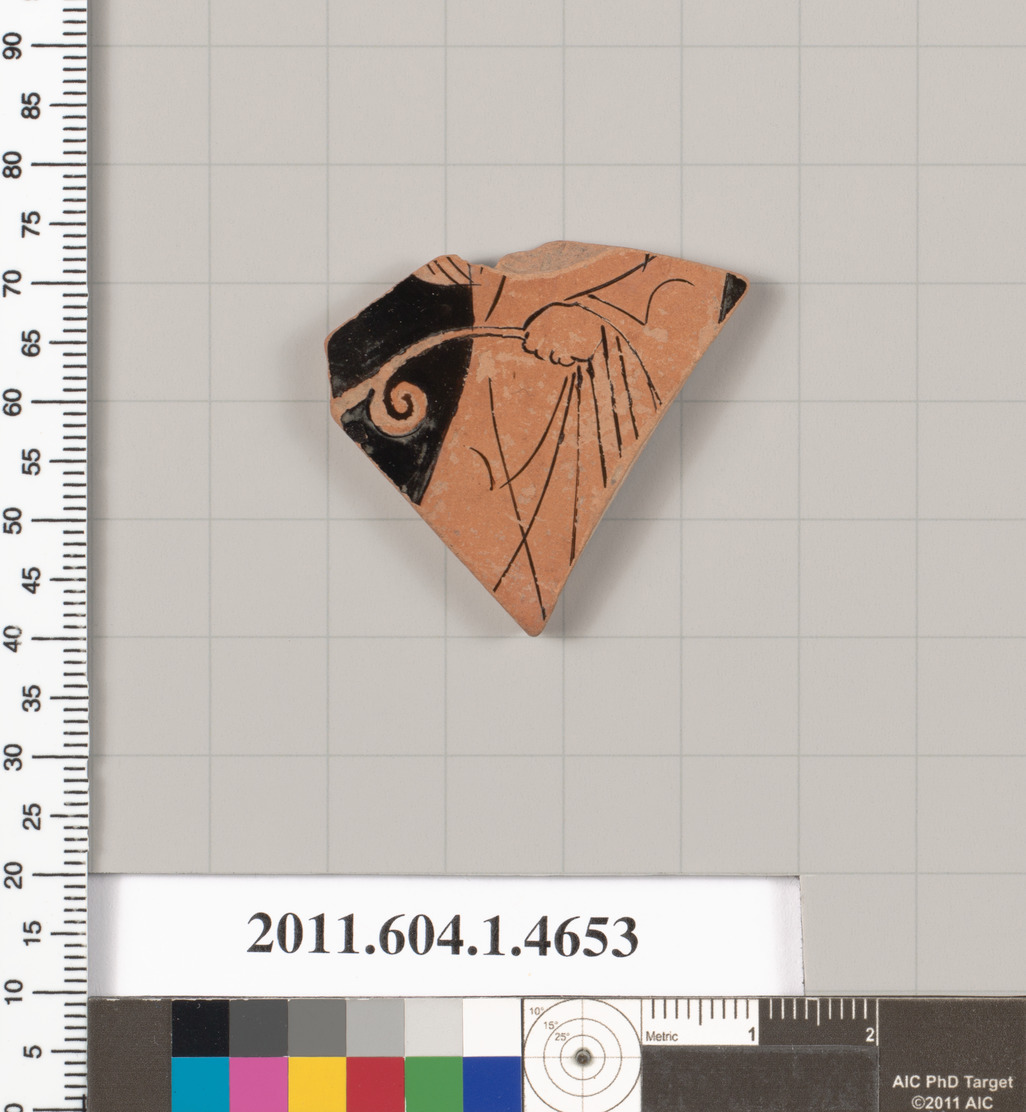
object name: kylix fragment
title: Terracotta fragment of a kylix (drinking cup)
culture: greek, attic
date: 475-451 BCE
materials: terracotta